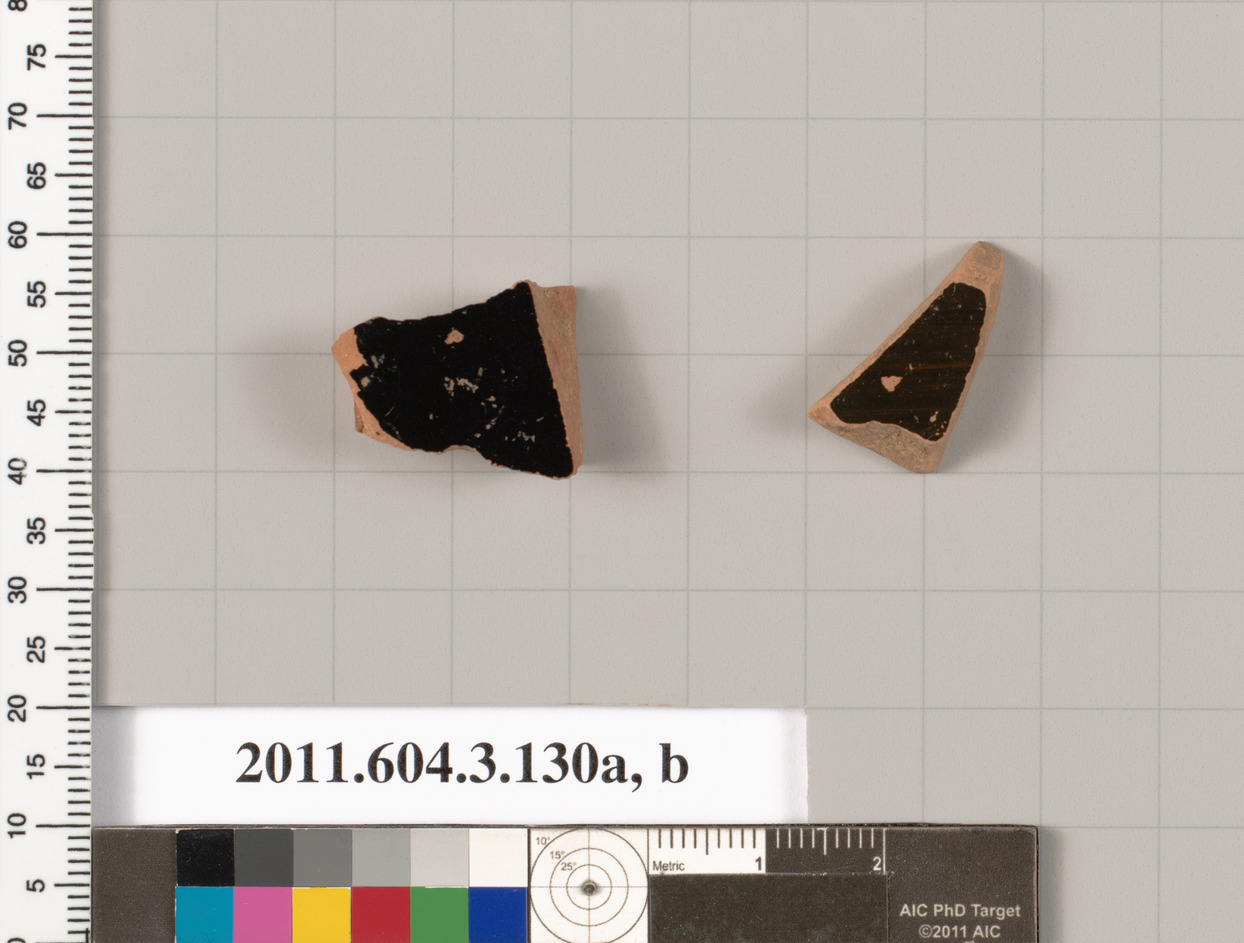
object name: amphora fragment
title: Terracotta fragments of amphorae (jars)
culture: greek, attic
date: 600-468 BCE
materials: terracotta